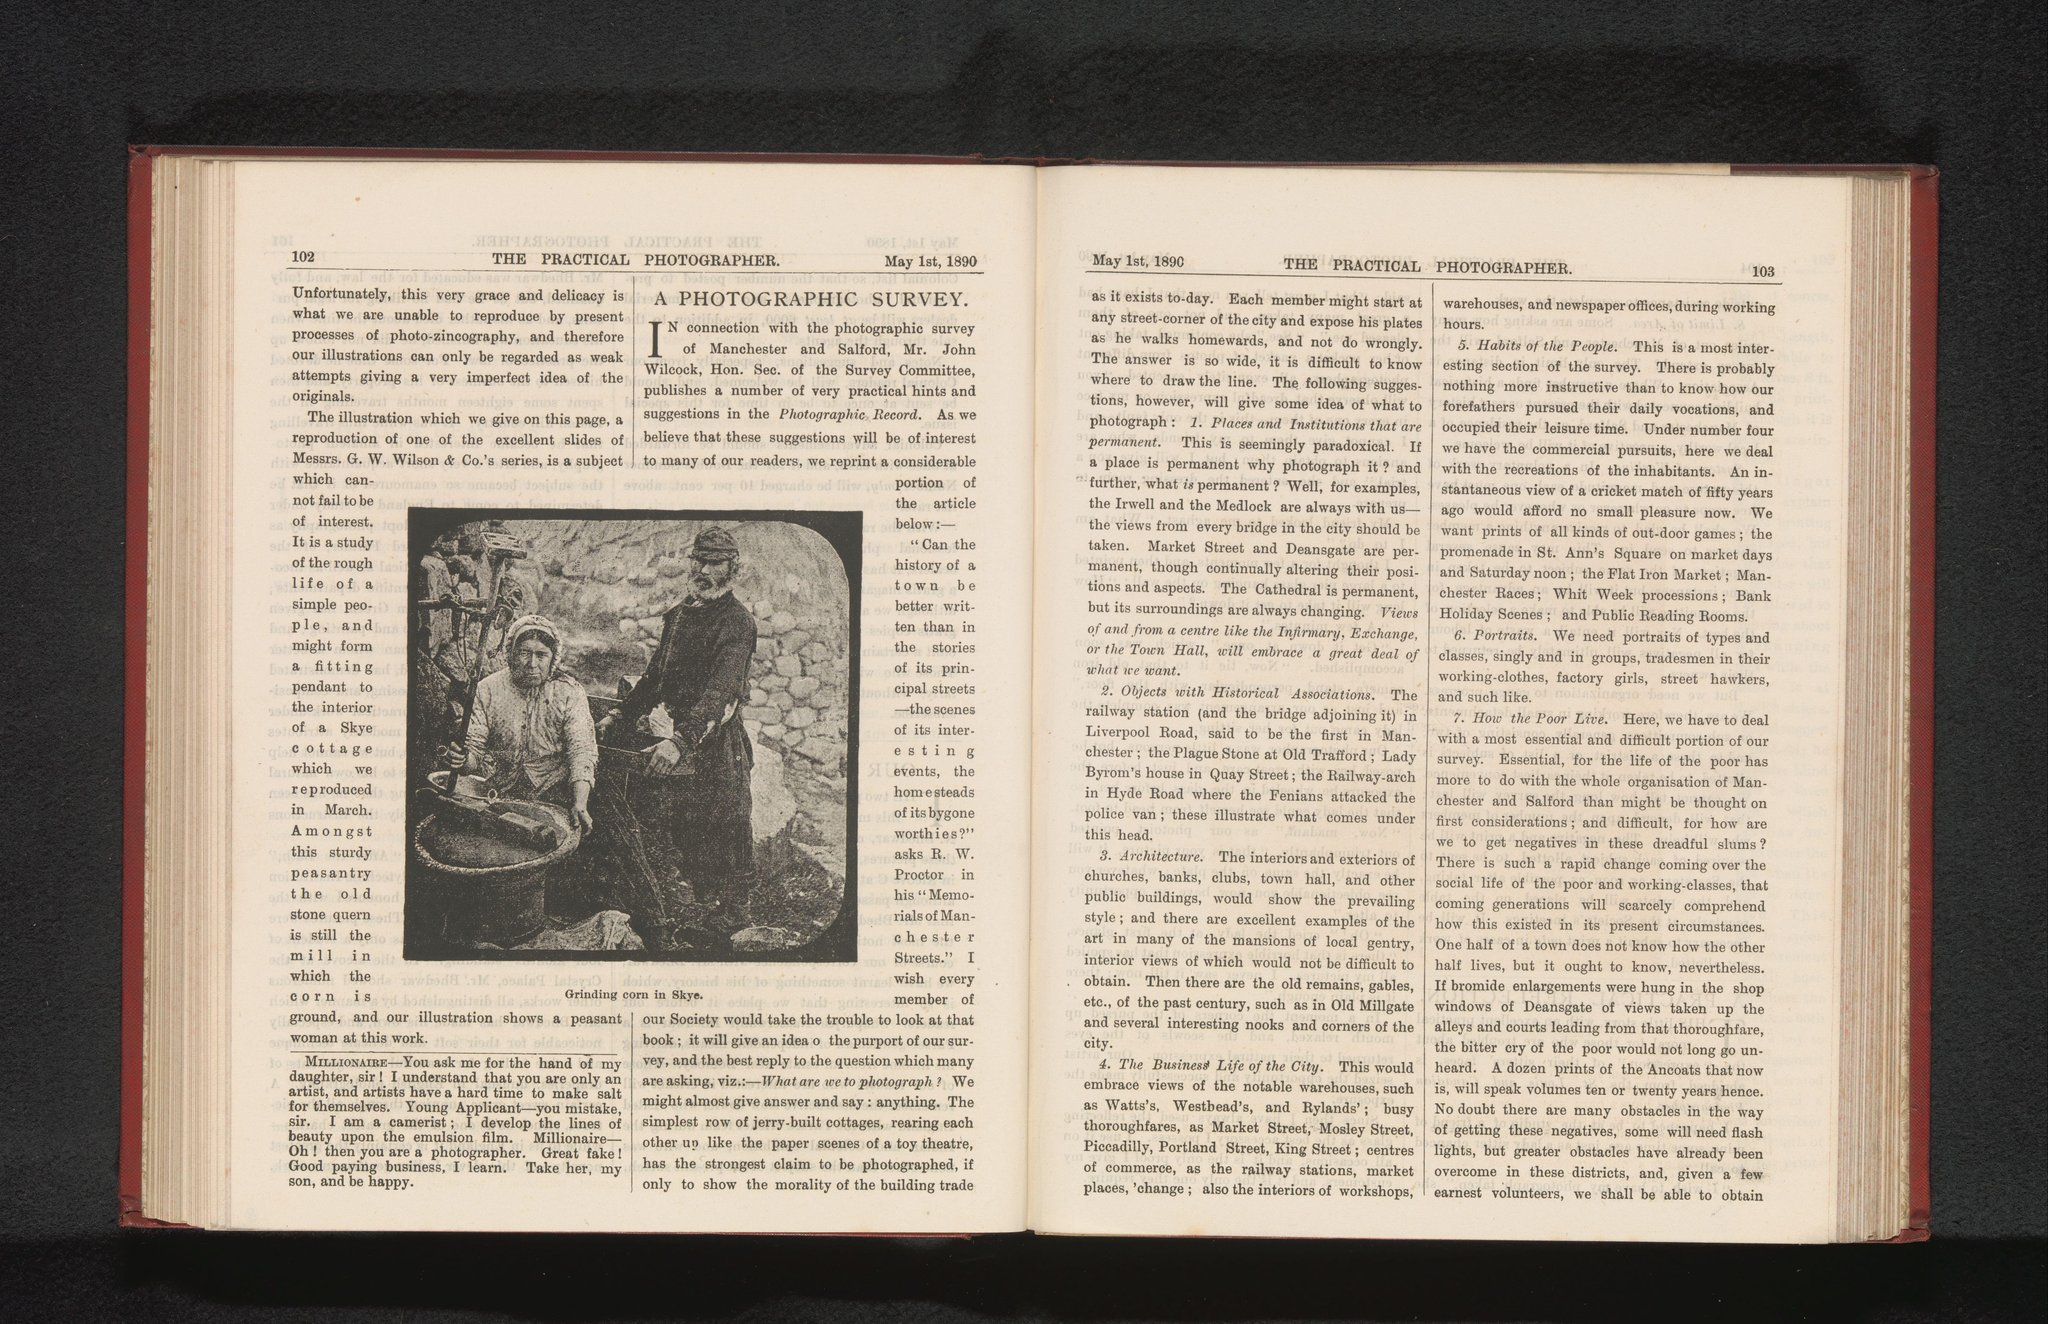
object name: photomechanical print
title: Man en een vrouw die mais malen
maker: Anonymous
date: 1885-1890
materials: paper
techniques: autotype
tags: grinding, milling (industrial processes) (+ labourers ~ crafts, industries, agriculture)